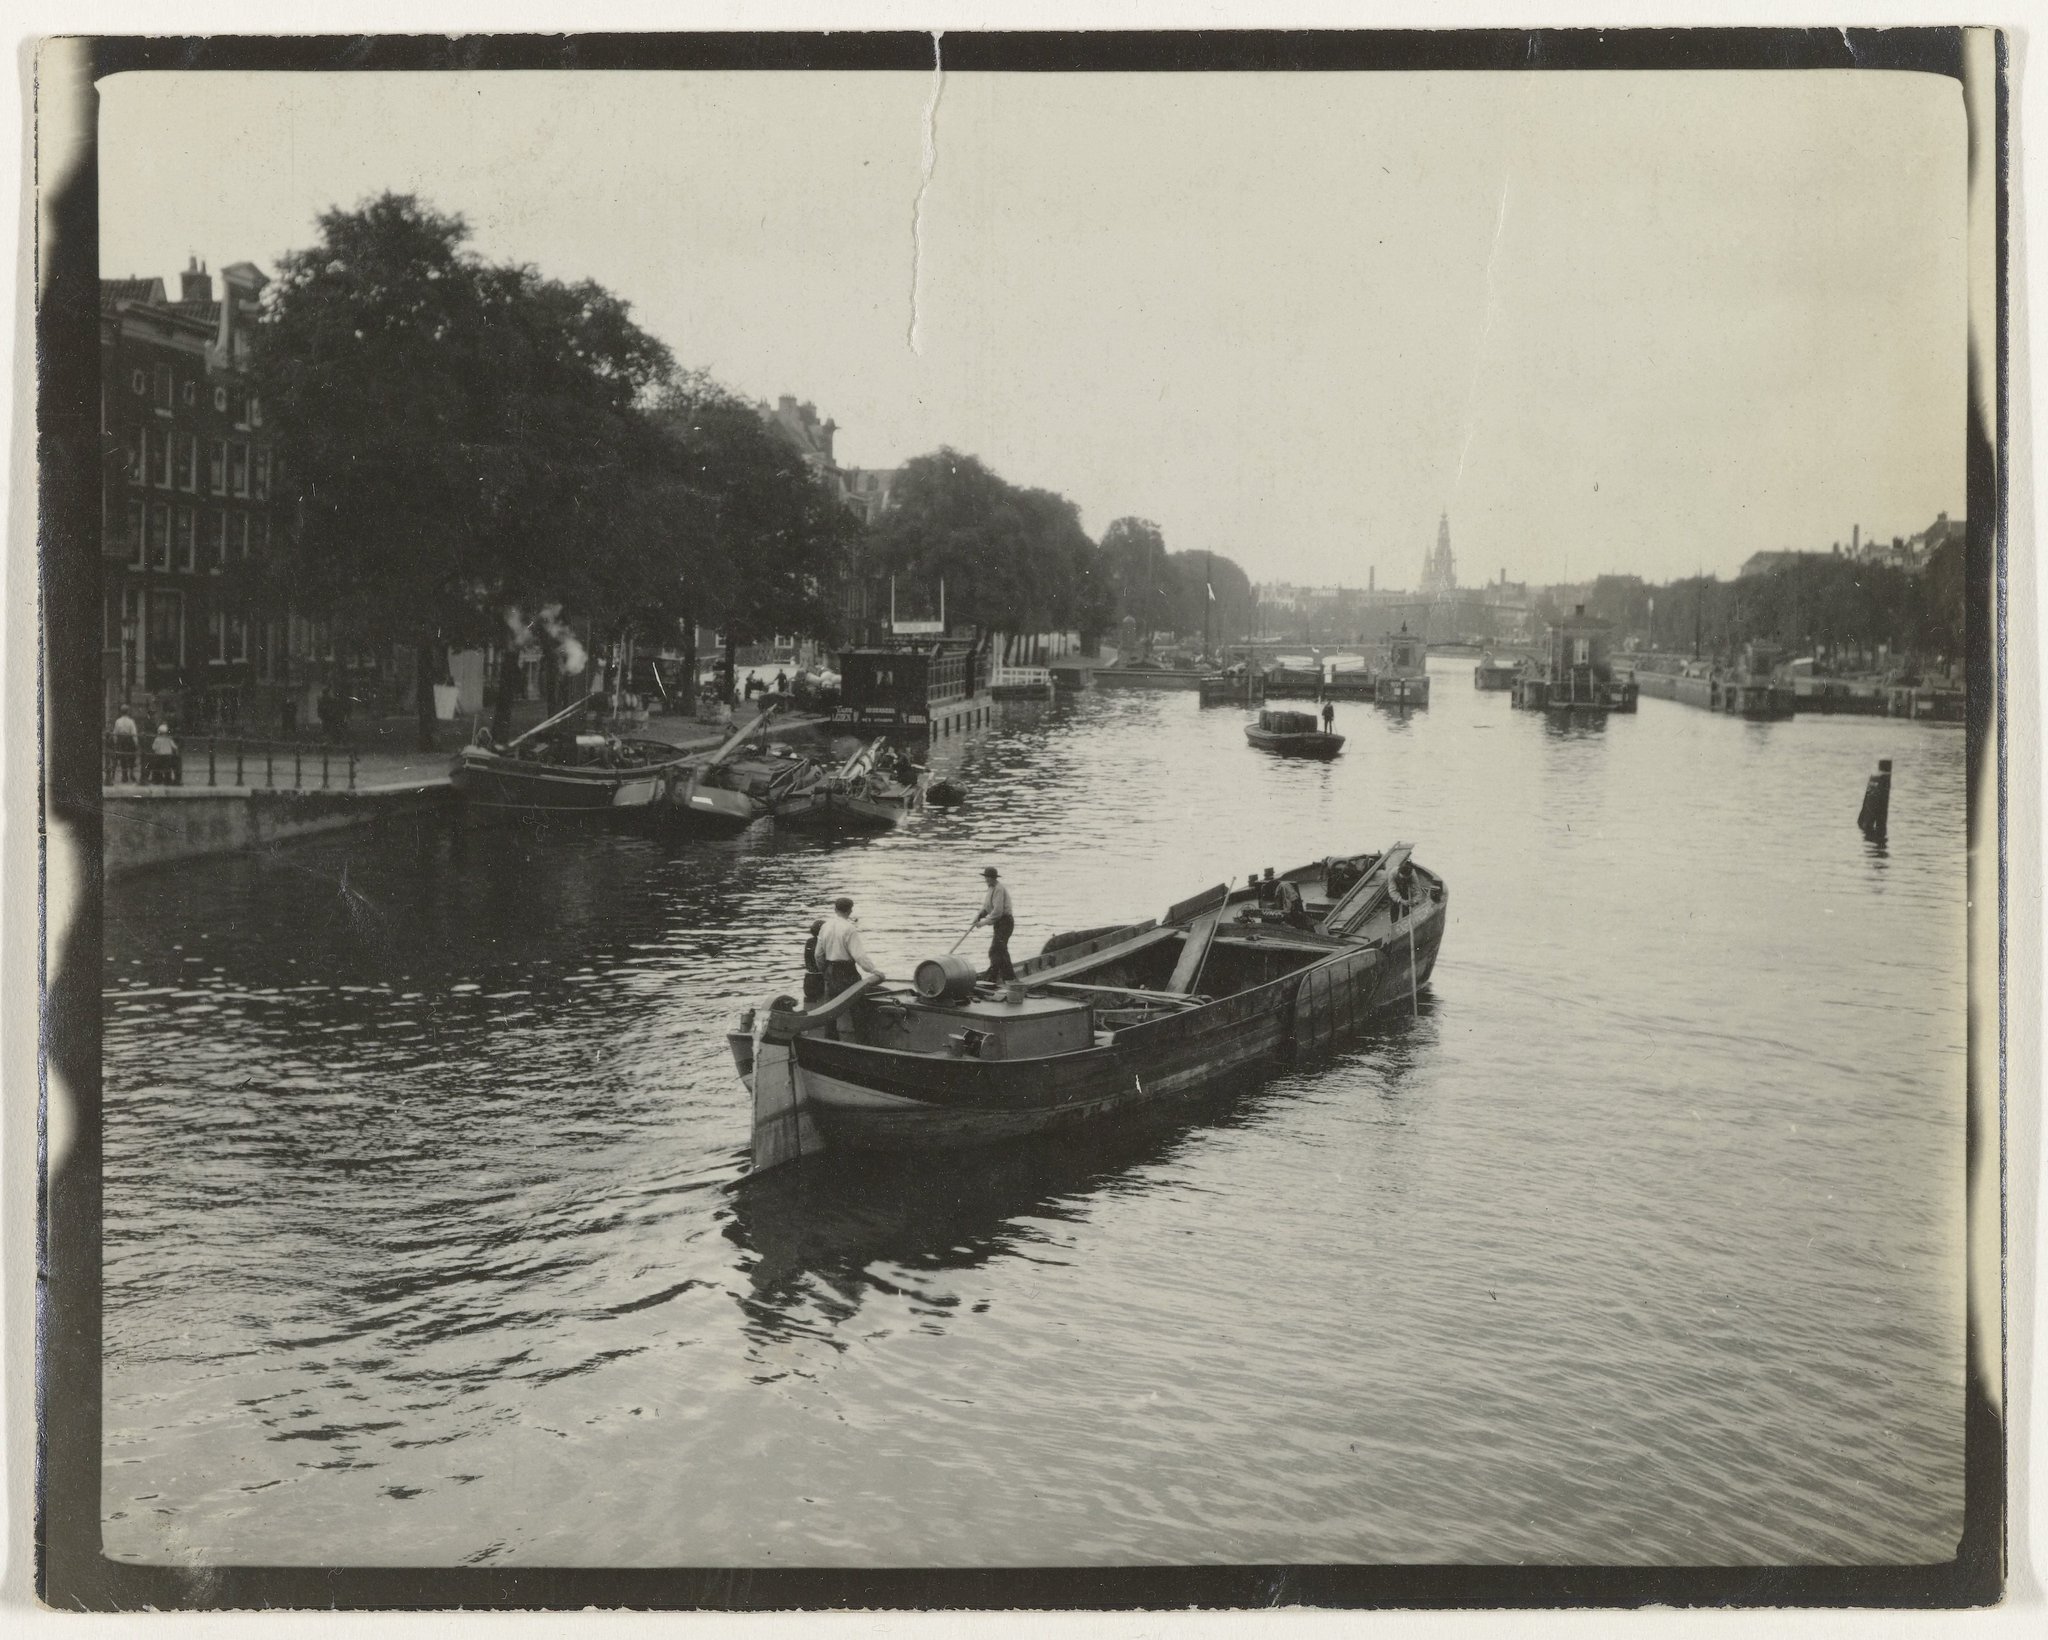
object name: photograph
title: Gezicht over de Amstel met de Amstelsluizen, Amsterdam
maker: Anonymous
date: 1900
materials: photographic support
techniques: gelatin silver print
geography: amsterdam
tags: motorized barge, canals, waters (in city), amsterdam